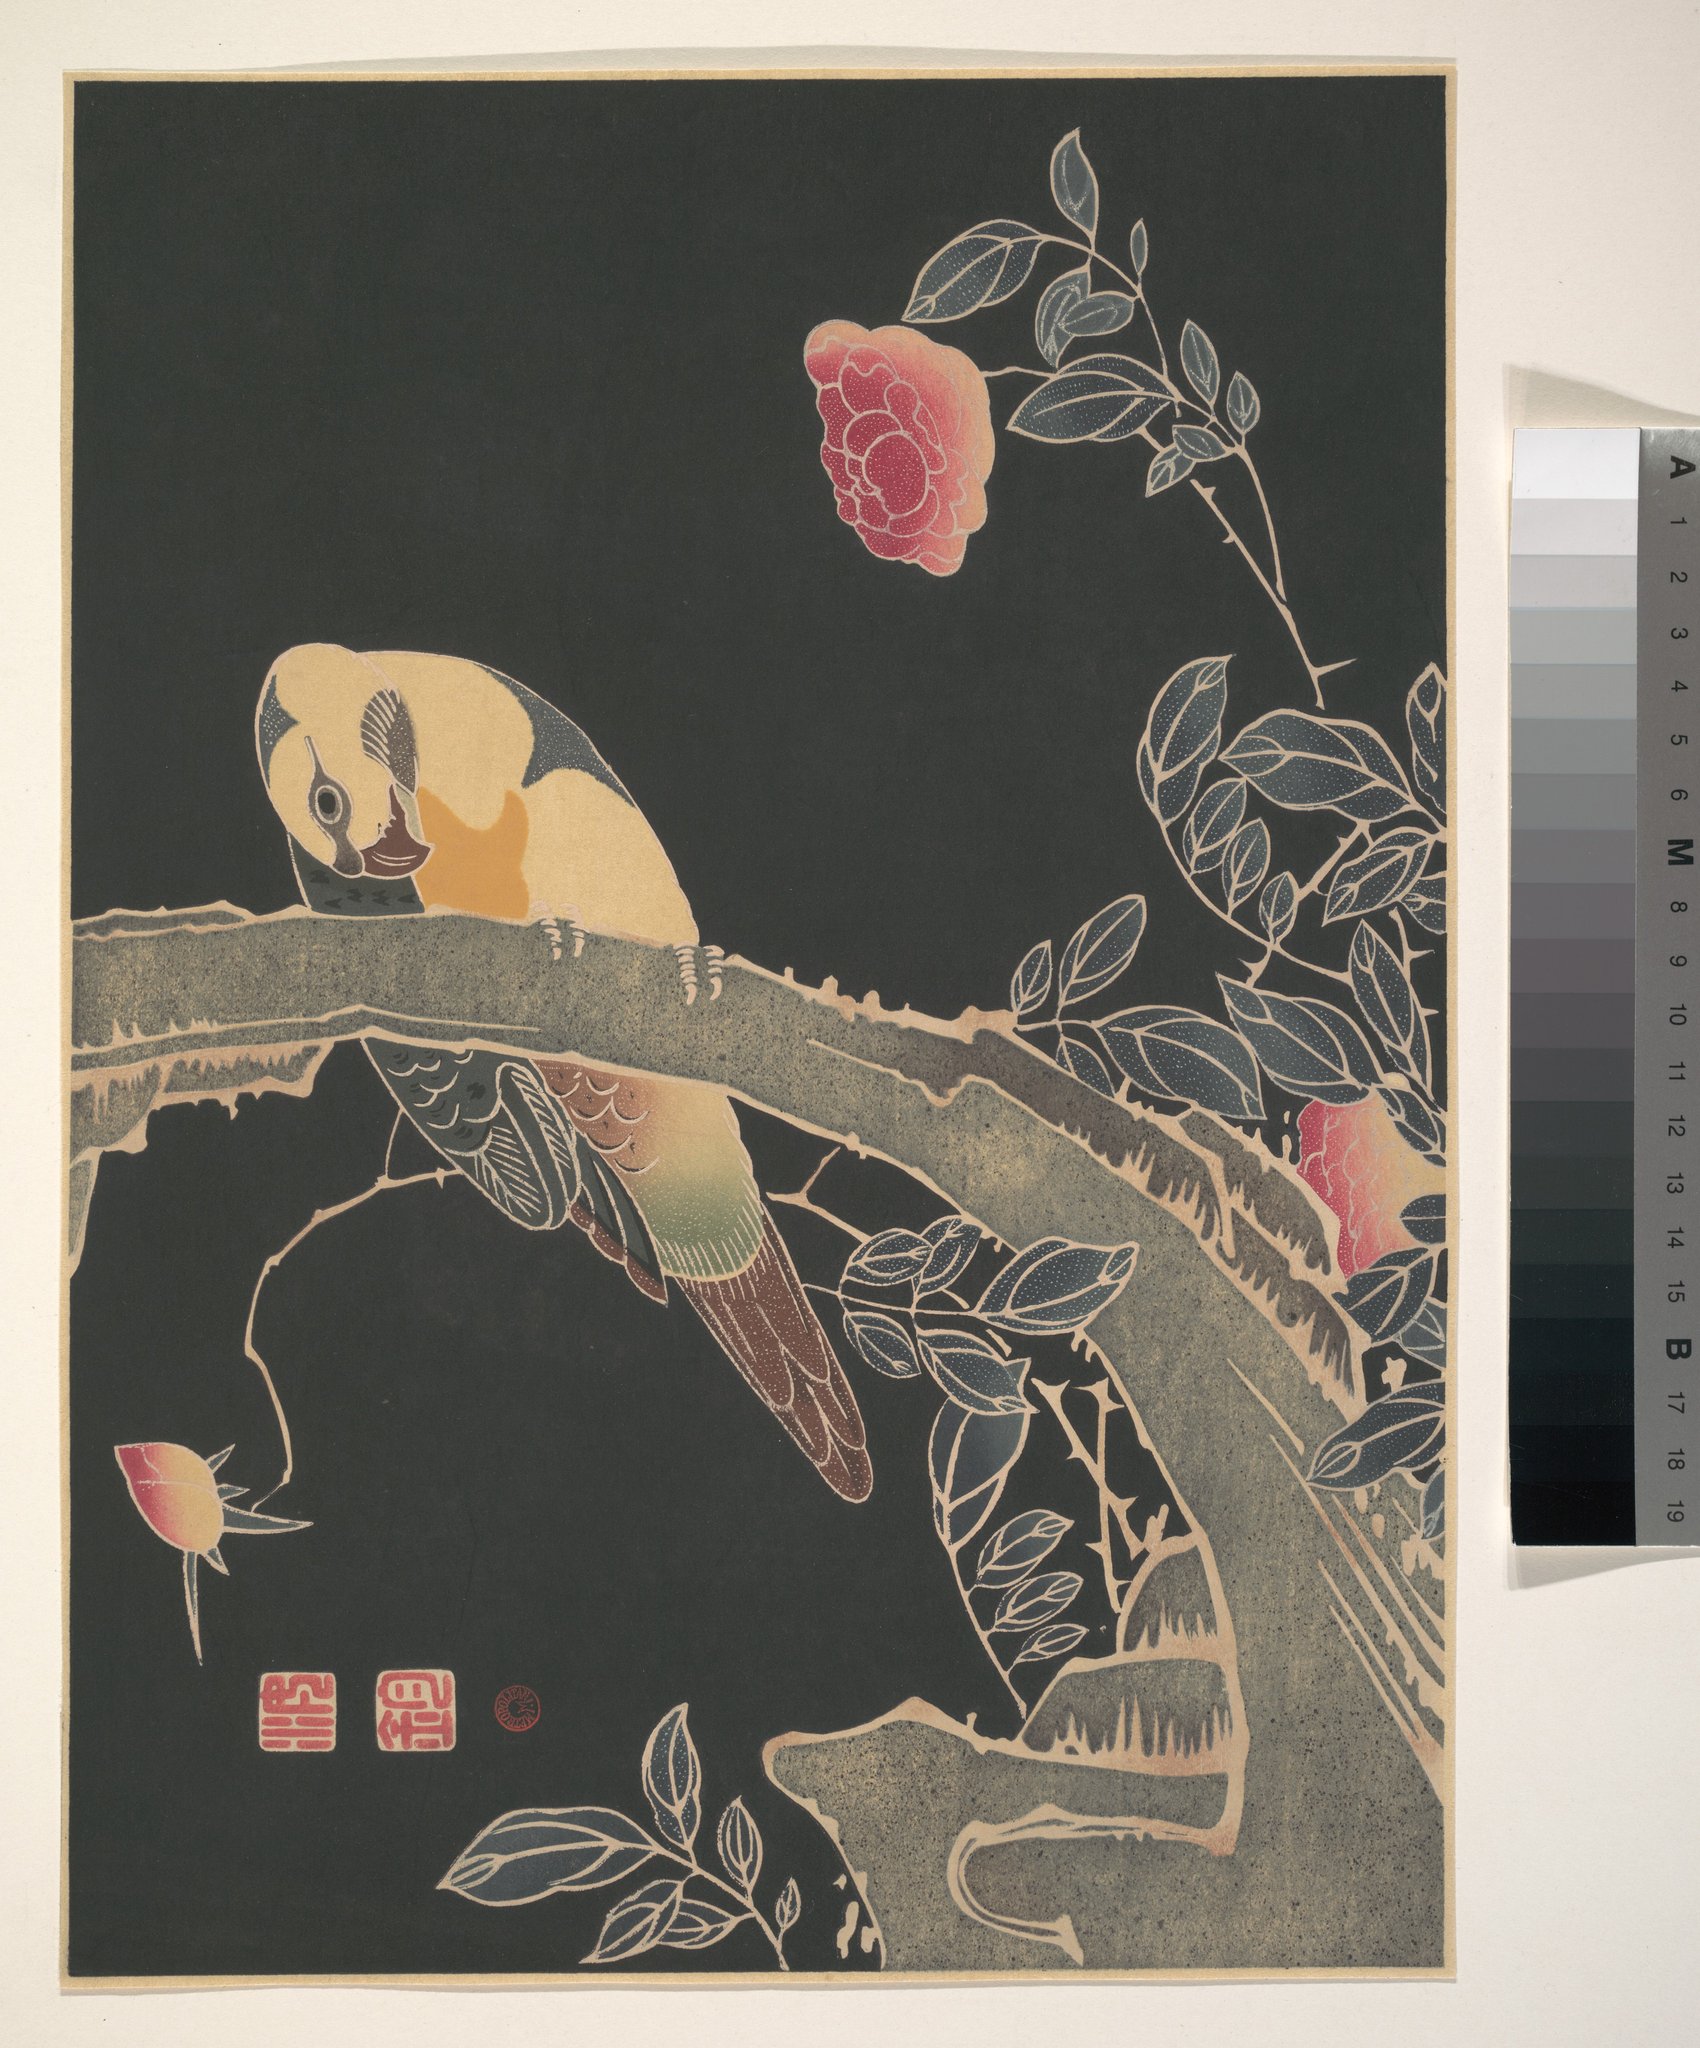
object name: reproduction of a print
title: Parrot on the Branch of a Flowering Rose Bush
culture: japanese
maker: itō jakuchū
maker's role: artist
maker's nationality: japanese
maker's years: 1716-1800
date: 1900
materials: ink, paper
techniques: woodblock print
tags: parrots,roses,leaves